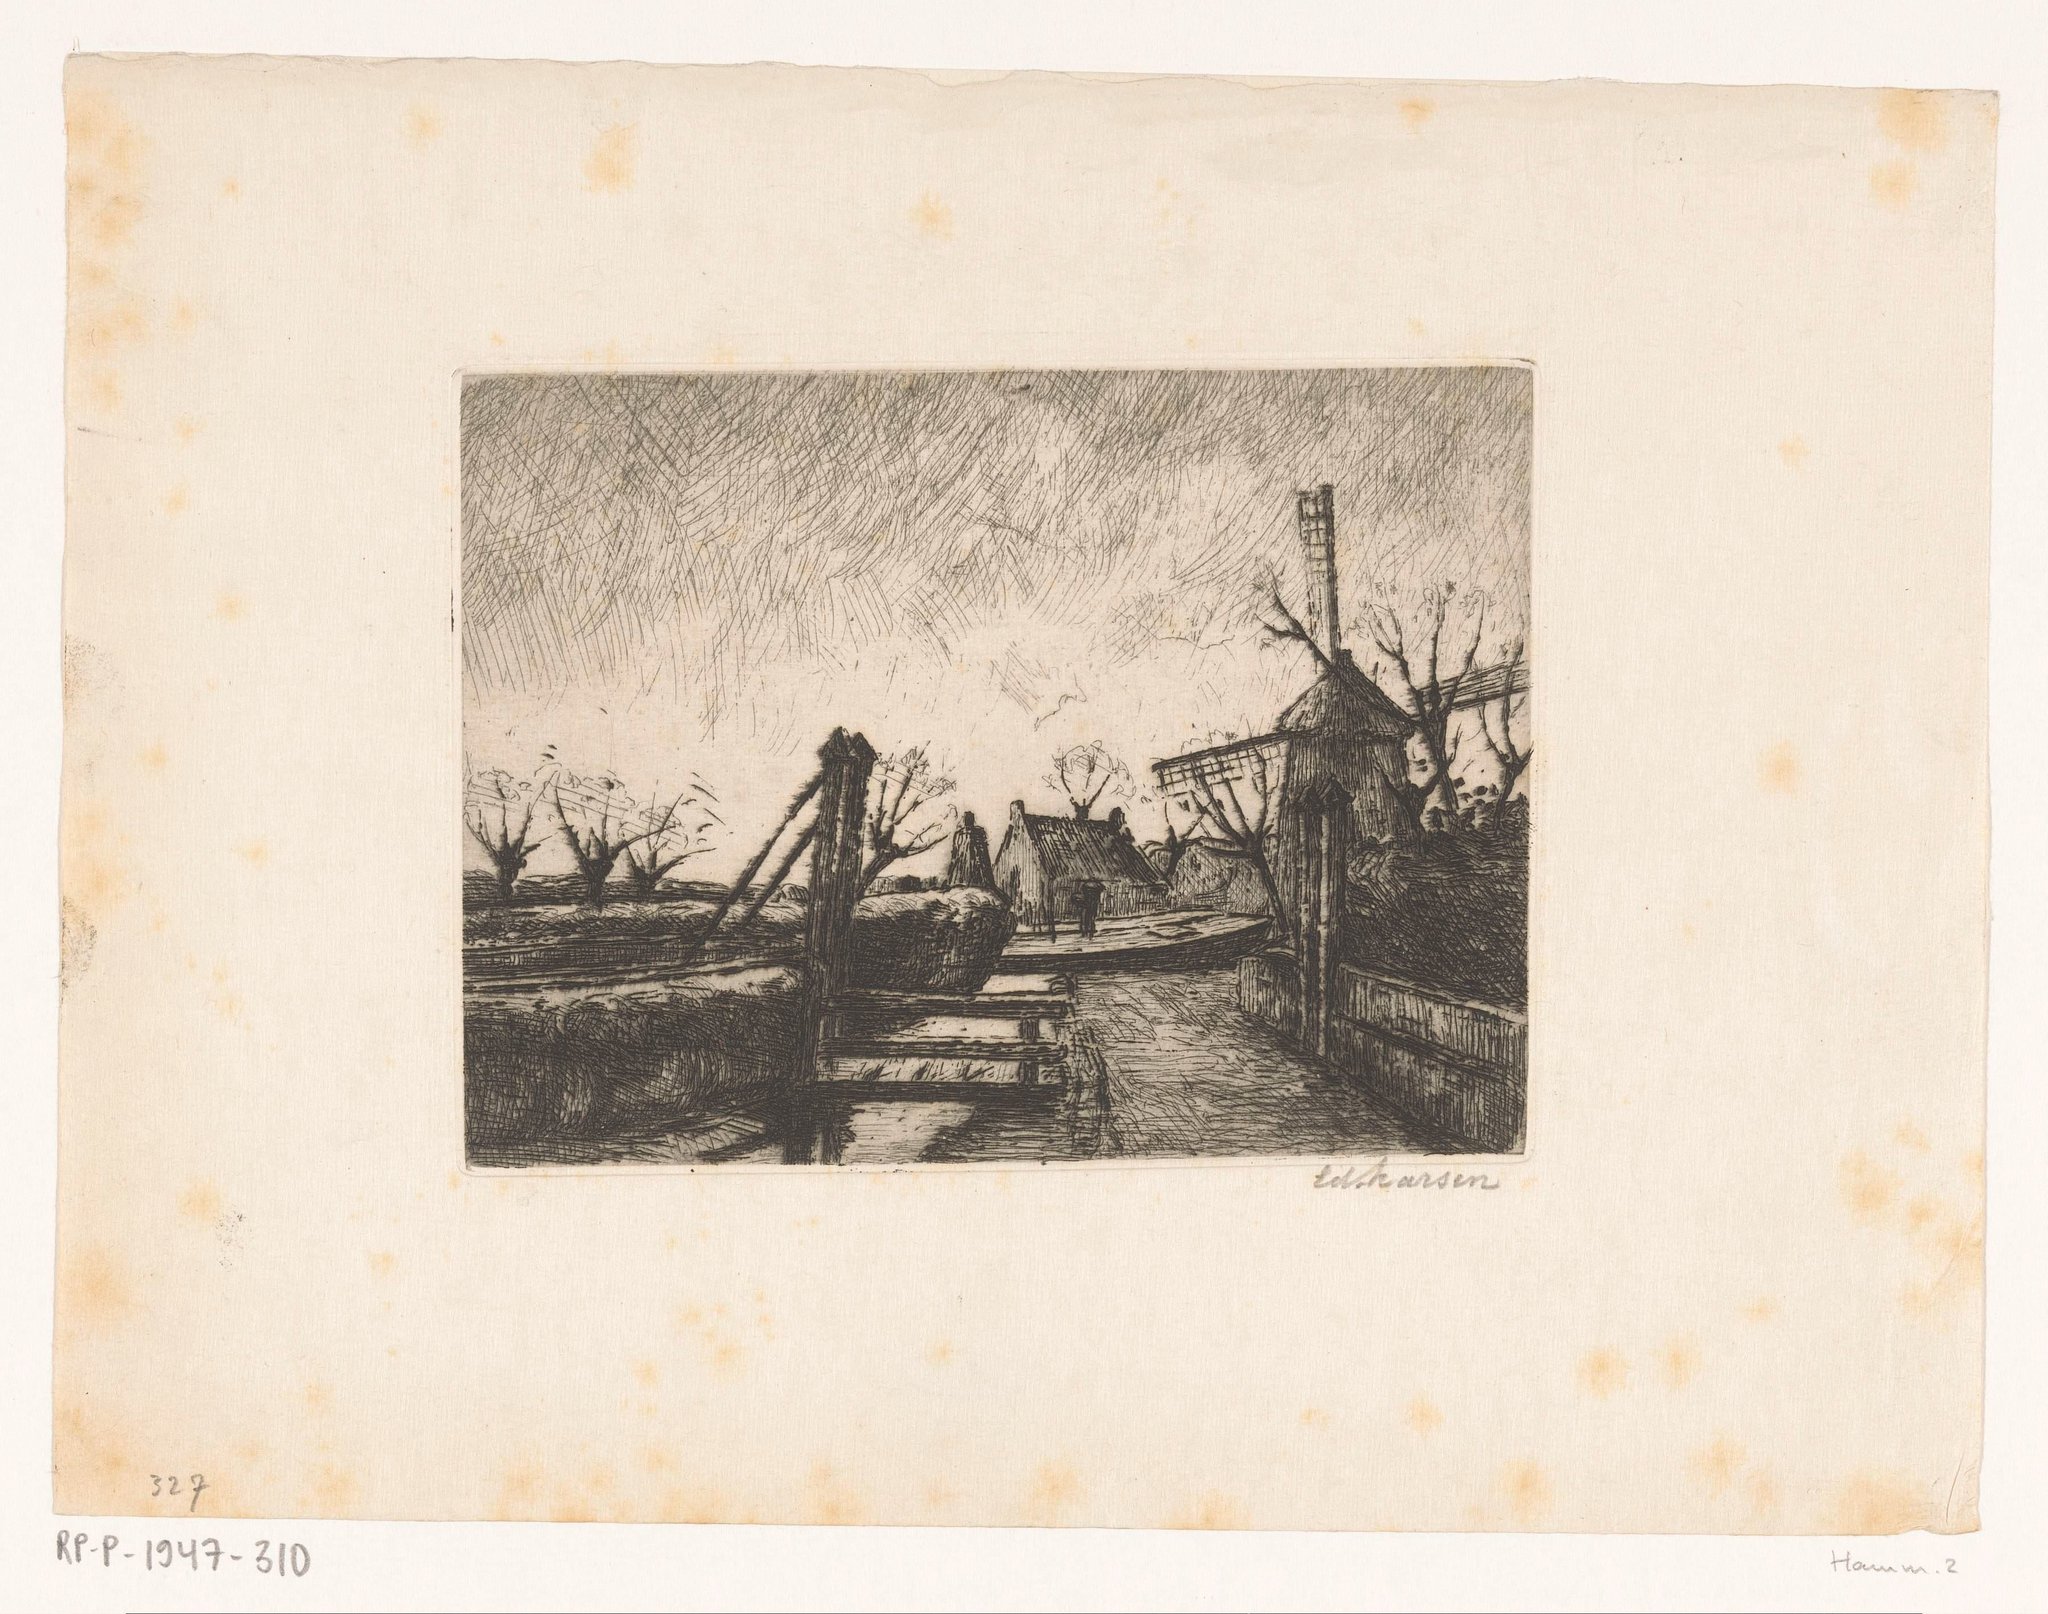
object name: print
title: Pad met brug langs een sloot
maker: eduard karsen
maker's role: draughtsman, painter, print maker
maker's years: 1860-1941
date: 1870-1941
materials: paper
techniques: etching, intaglio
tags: windmill in landscape, small canal, ditch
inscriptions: collector's mark: Lugt 2228